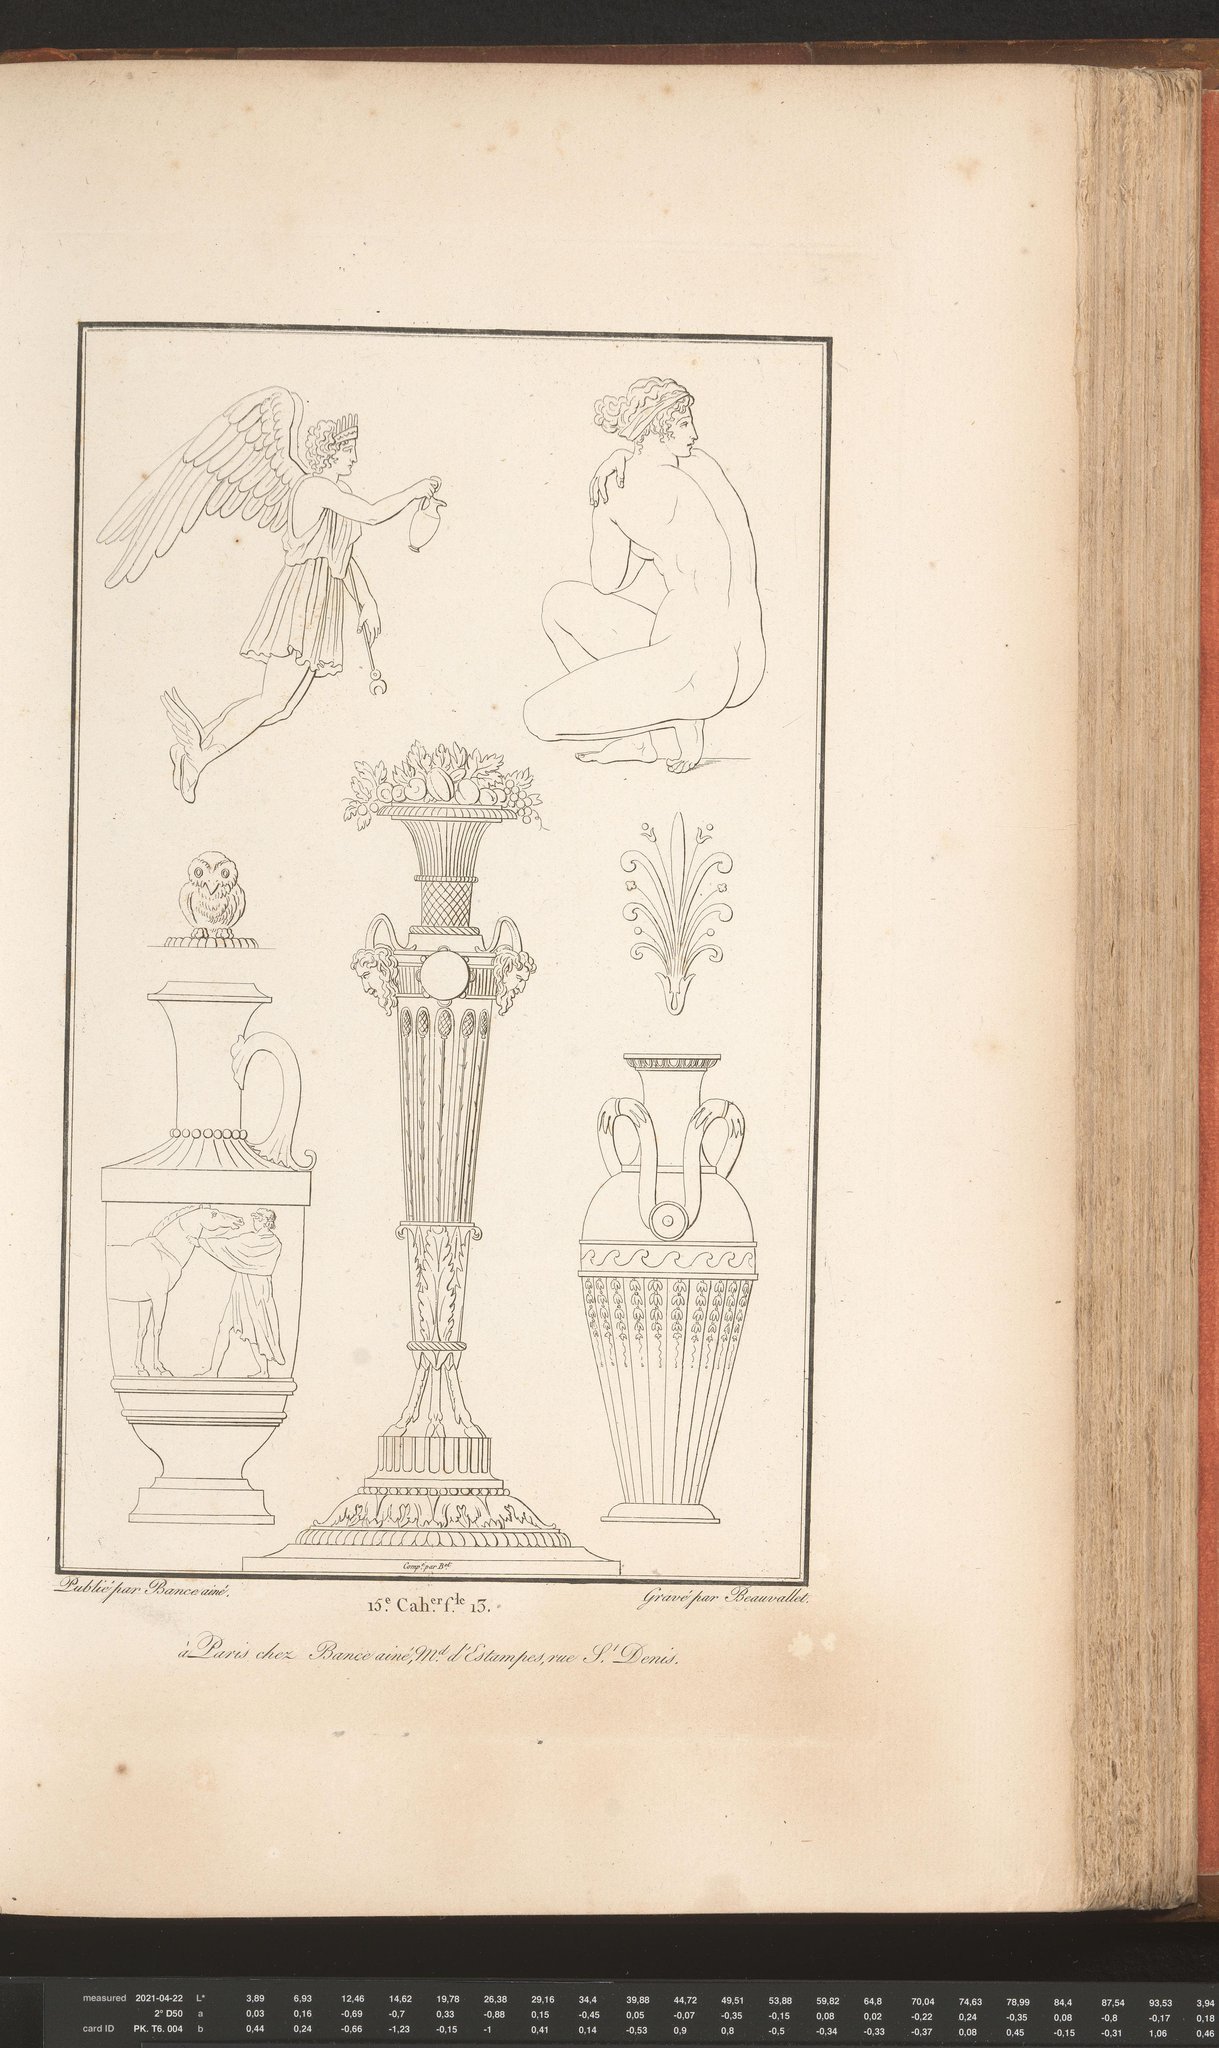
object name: ornament print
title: Diverse ornamenten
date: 1820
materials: paper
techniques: etching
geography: paris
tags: vase ~ ornament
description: Ornamentprent met diverse vazen en figuren. Onderdeel (15e. Cah. f.le 13) van het prentalbum met twee series van in totaal 138 ornamentprenten door Beauvallet en Normand, 'Fragmens d'Ornemens dans le Style Antique'.